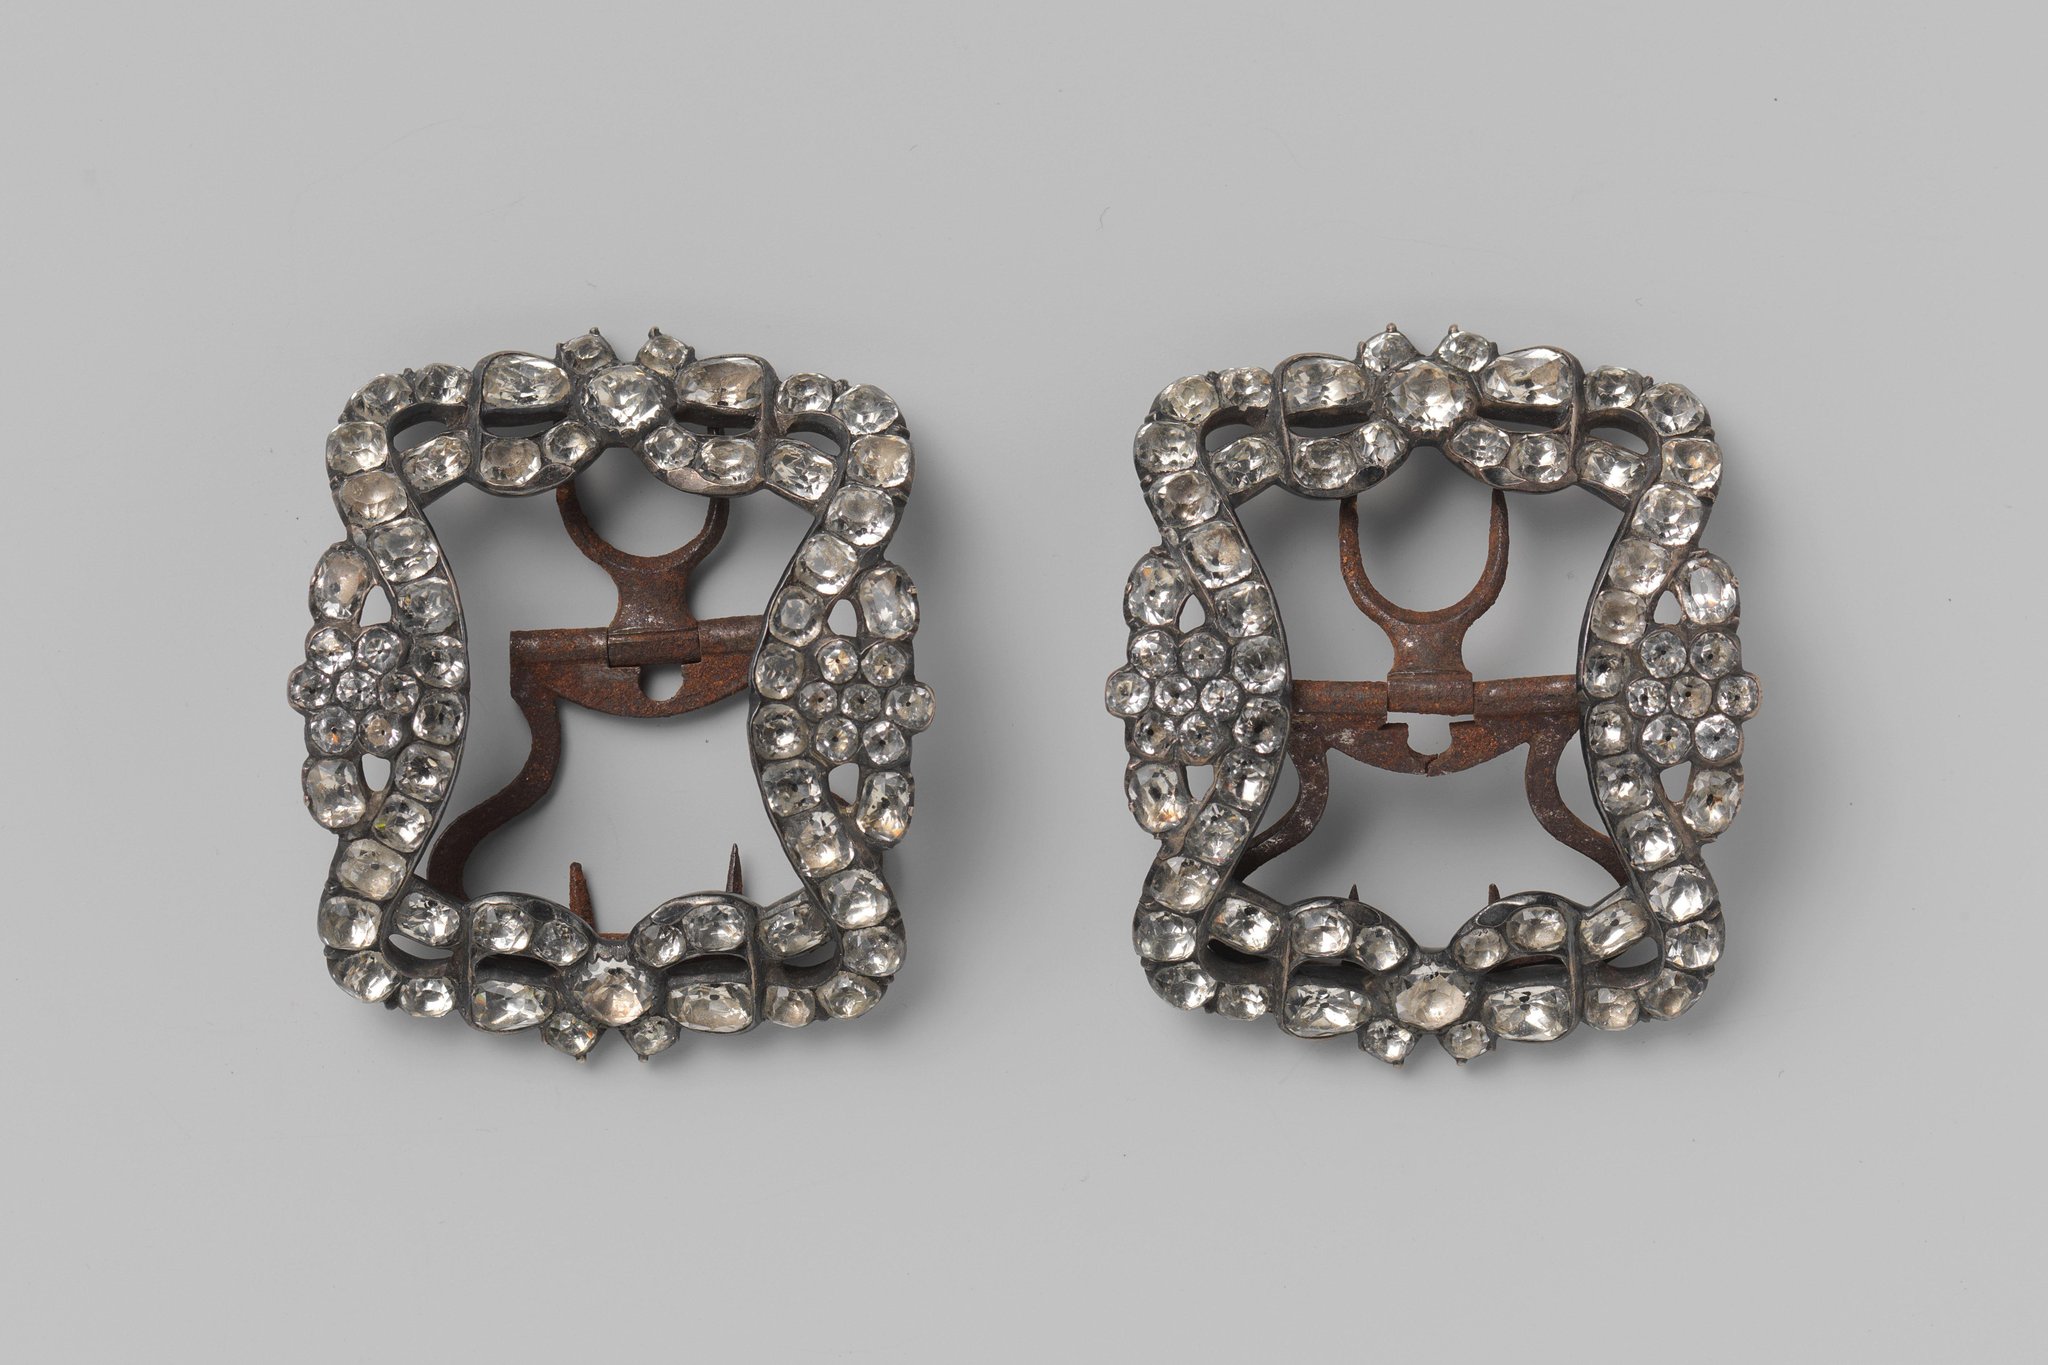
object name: shoe buckle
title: Schoengesp van stras met stalen pin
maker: Anonymous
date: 1400-1950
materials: paste, steel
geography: western europe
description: Schoengesp van stras met een stalen pin, gedecoreerd met twee bloemen en twee strikken.